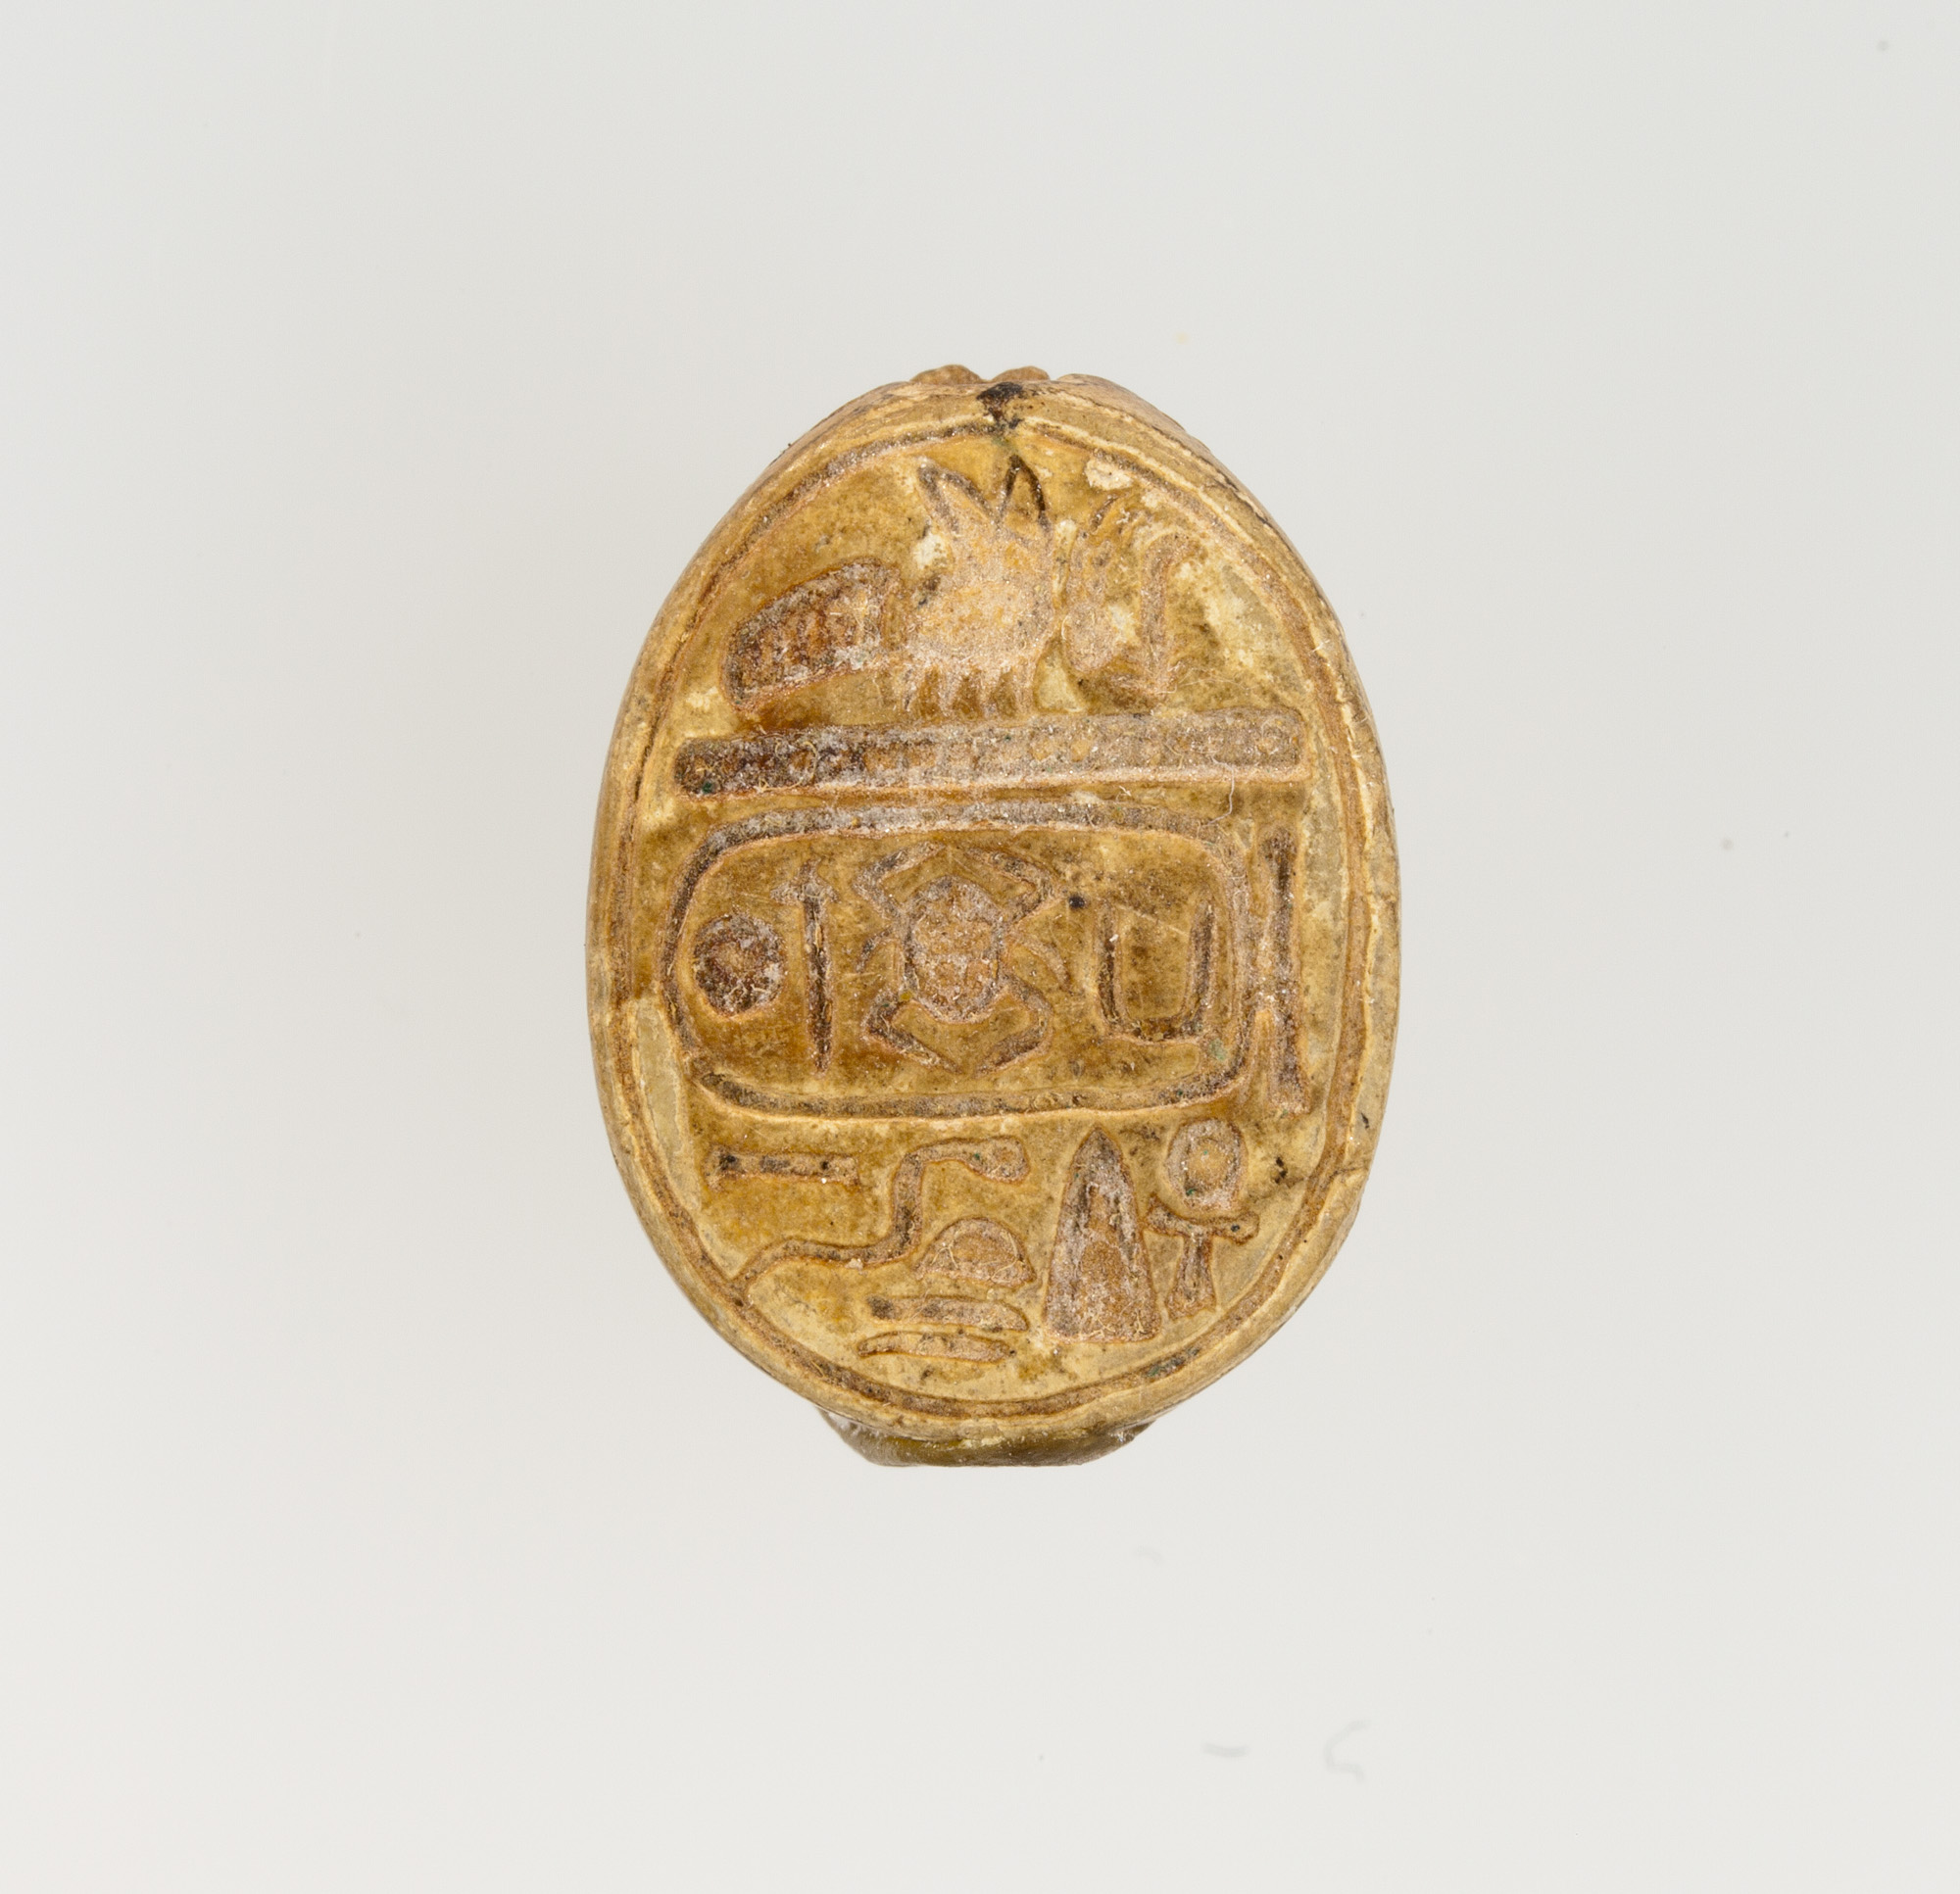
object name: scarab, thutmose i, aakheperkare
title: Scarab Inscribed with the Throne Name of Thutmose I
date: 1504-1492 BCE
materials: stone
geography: egypt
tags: hieroglyphs,scarabs